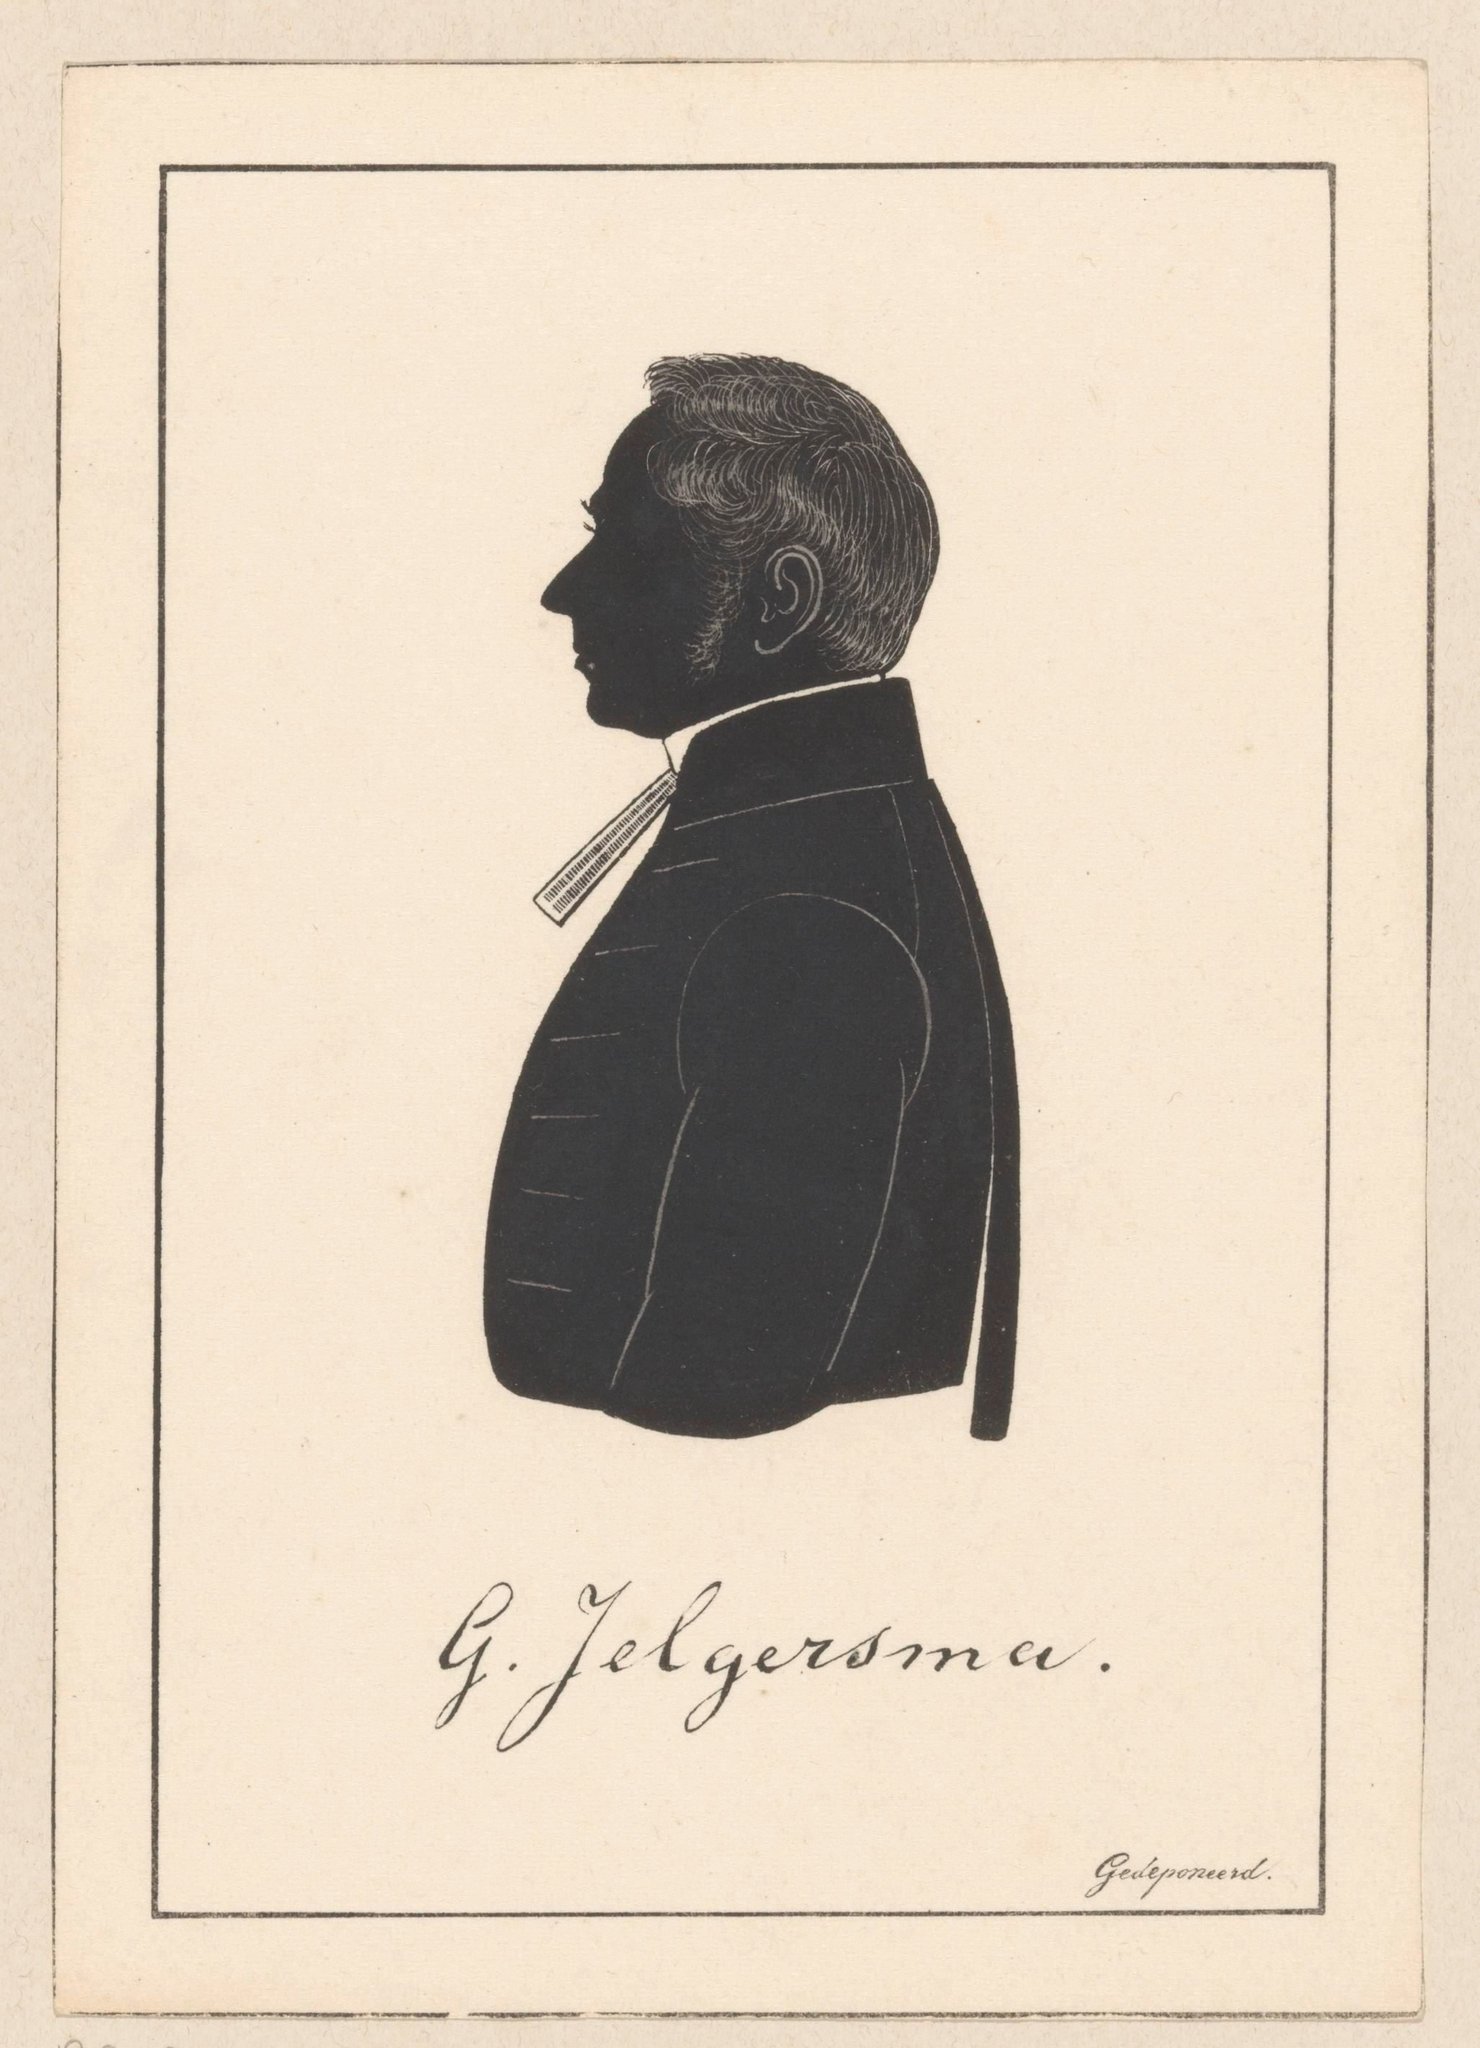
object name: print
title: Silhouetportret van G. Jelgersma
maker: pieter barbiers (iv)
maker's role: painter, print maker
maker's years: 1798-1848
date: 1809-1848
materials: paper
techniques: hand coloring, lithograph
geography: netherlands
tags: historical persons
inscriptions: collector's mark: Lugt 2228, : ‘Gedeponeerd.’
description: Onder het portret de signatuur van de geportretteerde.